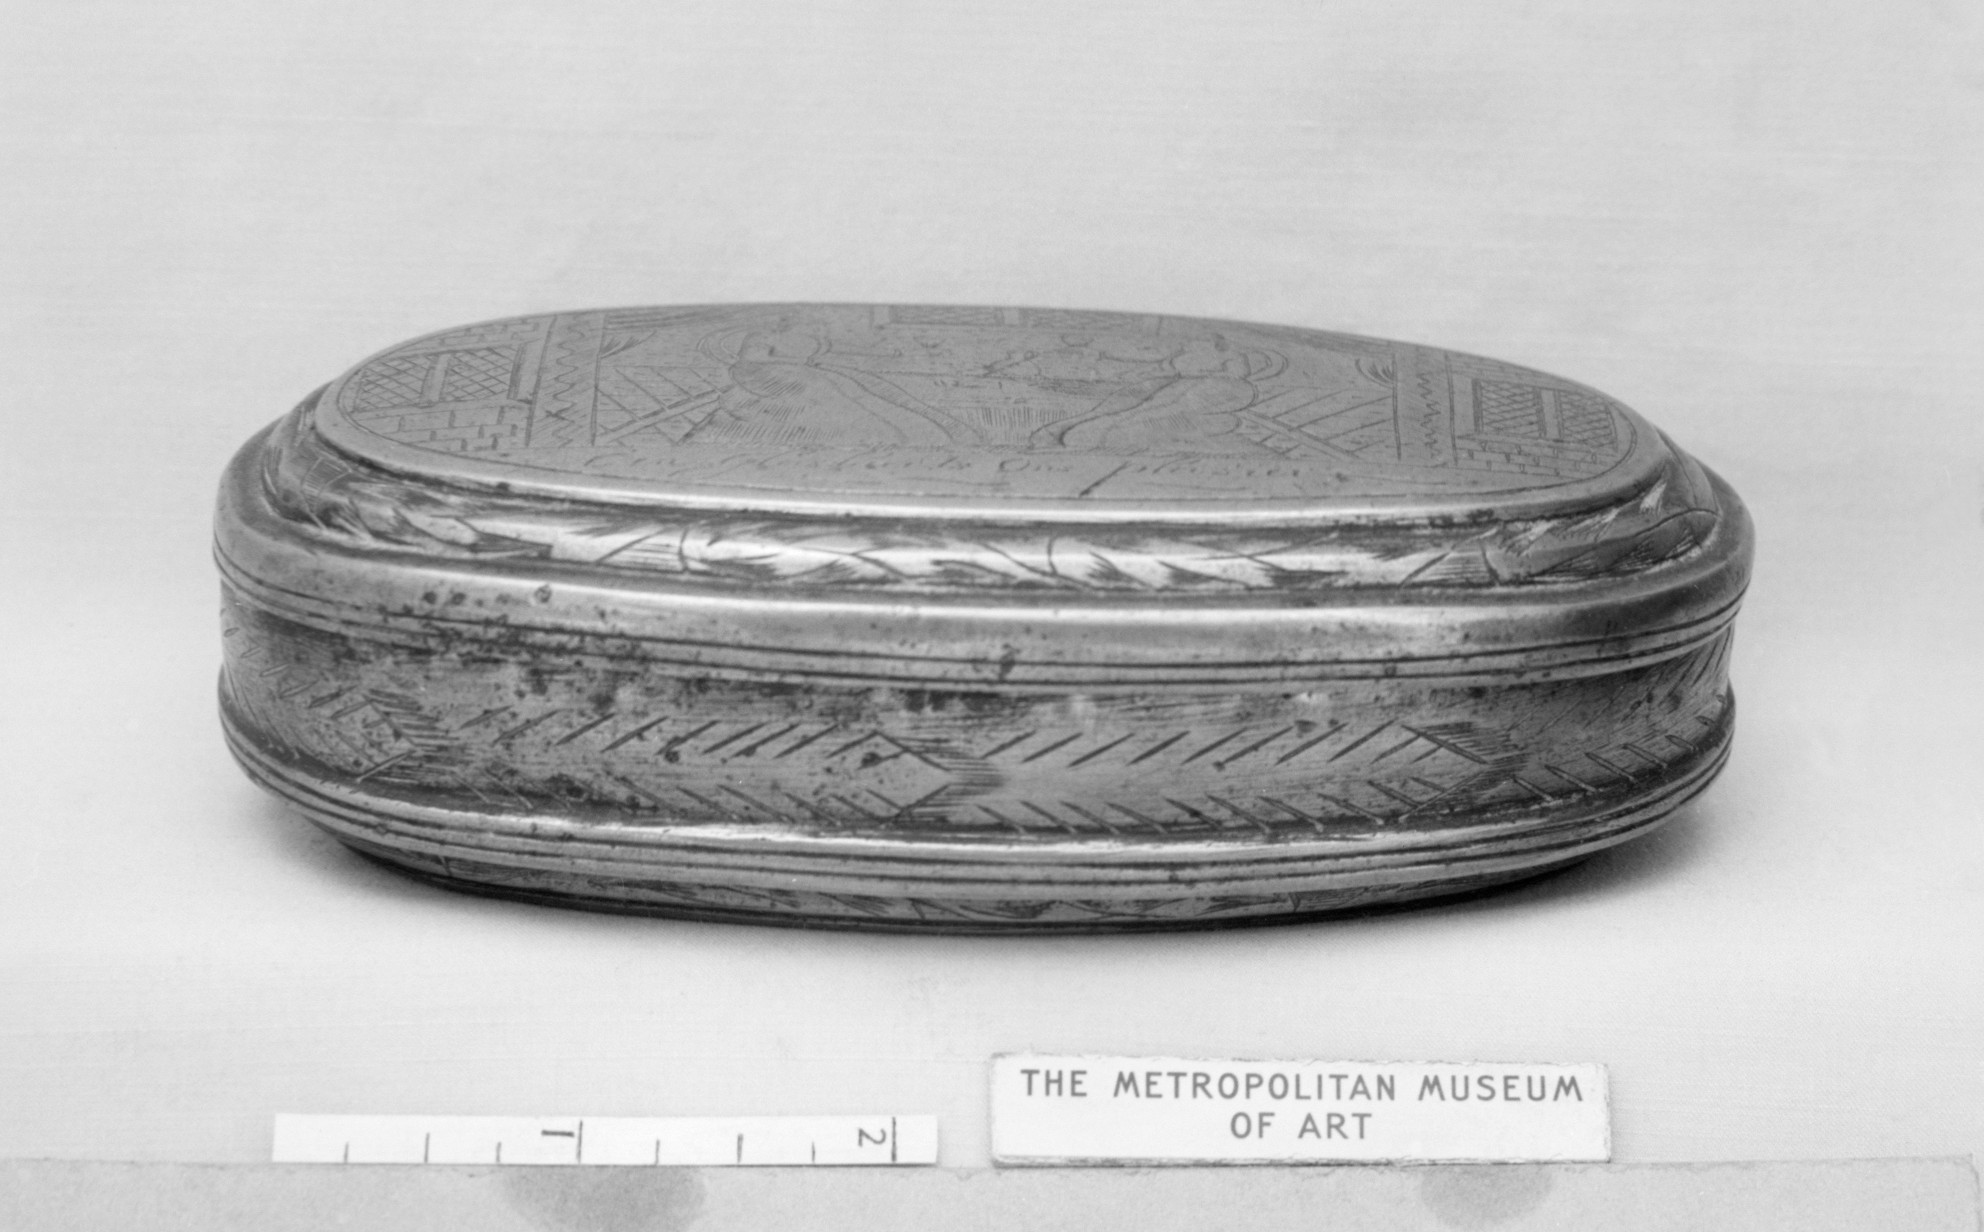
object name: tobacco box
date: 1601-1800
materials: brass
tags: women,drinking